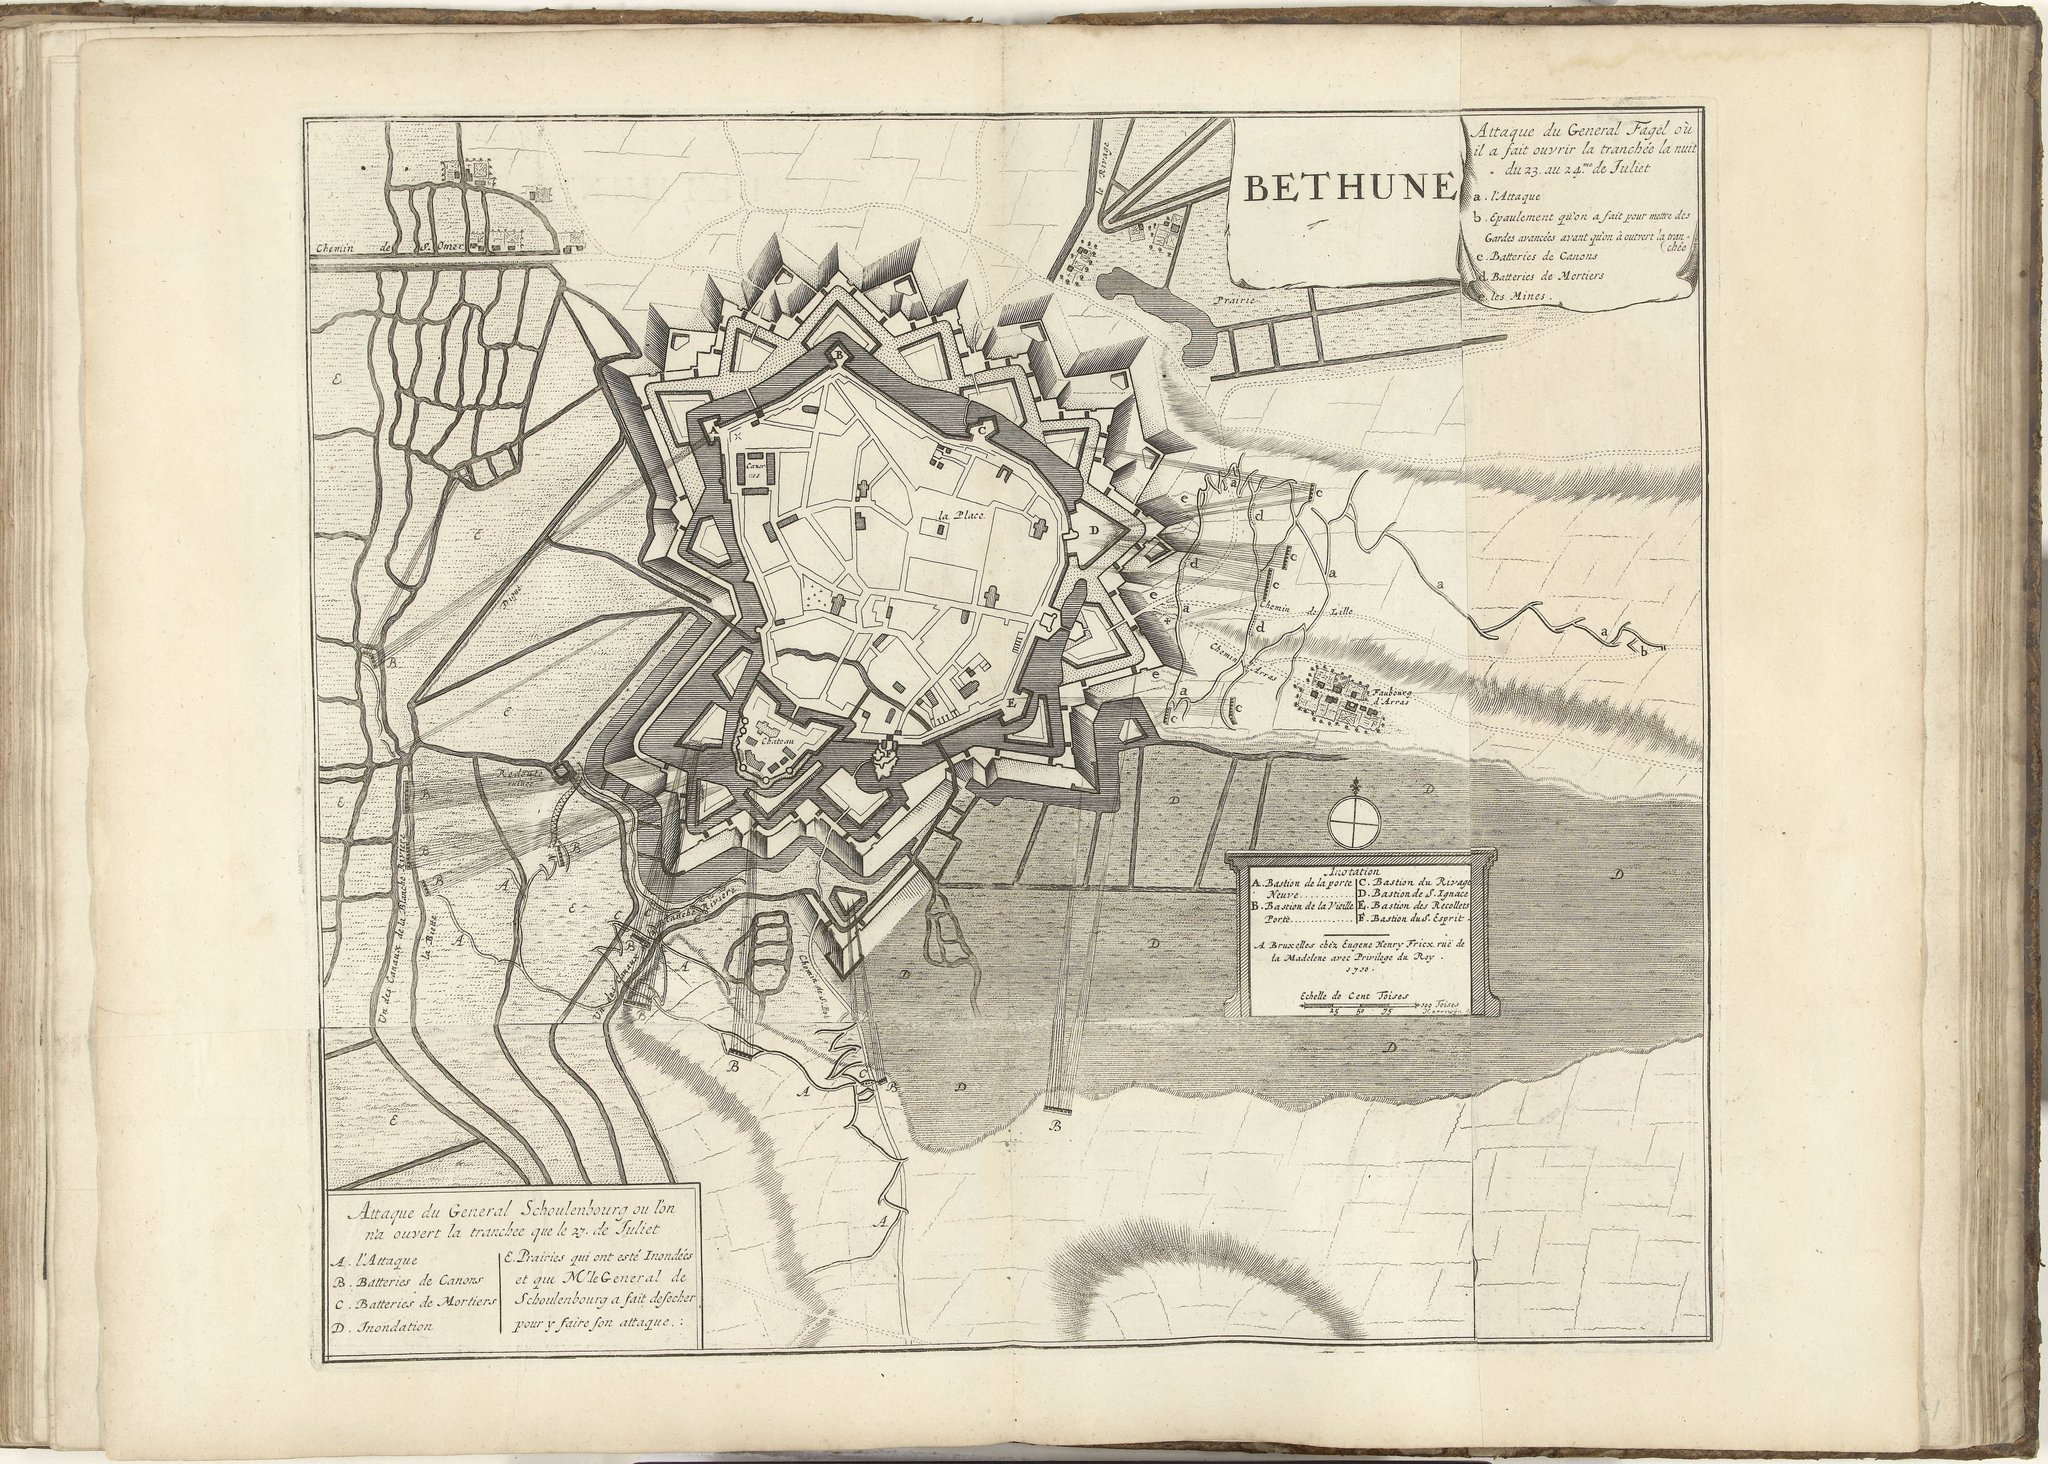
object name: print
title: Kaart van de aanvallen op Béthune, 1710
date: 1710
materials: paper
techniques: etching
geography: brussels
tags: françois nicolaas fagel, siege, position war, maps of cities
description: Plattegrond van de stad Béthune met de aanvallen op de stad door de Geallieerden onder generaal Fagel op 23-24 juli en onder generaal Schoulenberg op 27 juli 1710. Linksonder de cartouche met de legenda A-E. Aan de rechterzijde van de prent is een strook aangeplakt (gedrukt van een aparte plaat) met de cartouche met de legenda a-e en een deel van het land. Onderdeel van een gebundelde verzameling van plannen van veldslagen en steden vermaard in de Spaanse Successieoorlog.